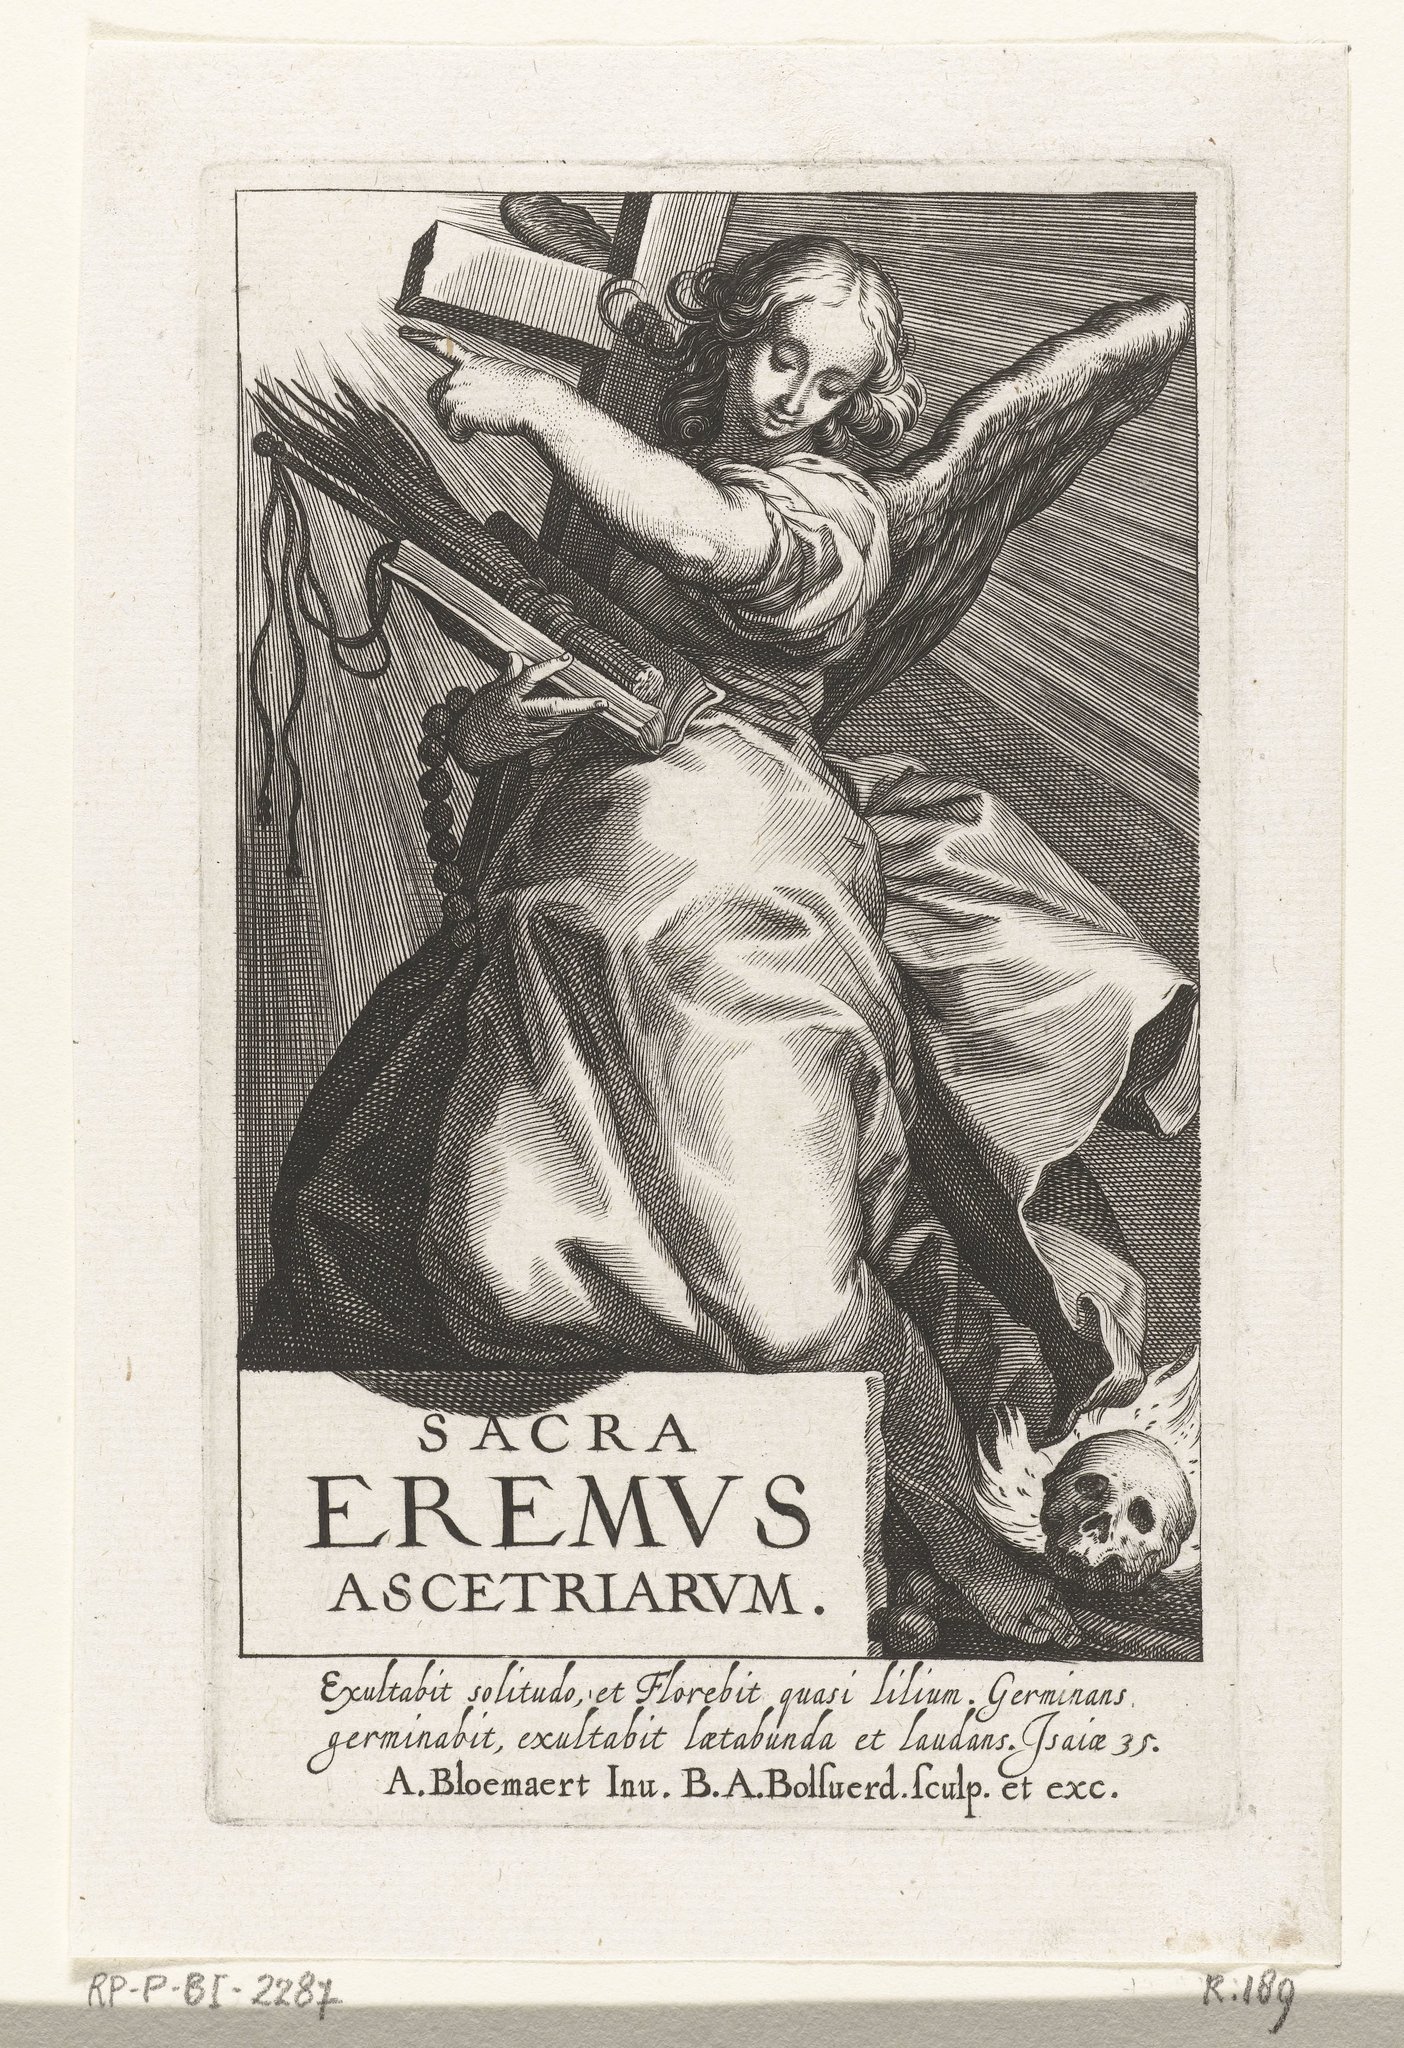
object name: print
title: Kluizenaressen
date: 1590-1612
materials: paper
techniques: engraving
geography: amsterdam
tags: ascetic life and practice, angels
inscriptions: collector's mark: Lugt 2228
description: Titelpagina voor: Sacra Eremus Ascetriarum, uitgever Boëtius Adamsz. Bolswert, 1612 of Hendrik Aertssen, Antwerpen 1619. Titelpagina voor de serie van vijfentwintig kluizenaressen in deze uitgaven met de titel Sacra Eremus Ascetriarum. In 1612 verscheen een ongebonden editie maar op basis van de gewijzigde opschriften en samenstelling van de serie kluizenaars wordt aangenomen dat de prenten van de uitgave 1619 ook in 1612 of iets daarvoor gedrukt werden. De serie kluizenaressen bleef vrijwel ongewijzigd in de ongebonden uitgave van 1612, dit compliceert de datering van de losse bladen in de collectie van het RMA, zie Roethlisberger 1993, p. 171-175.